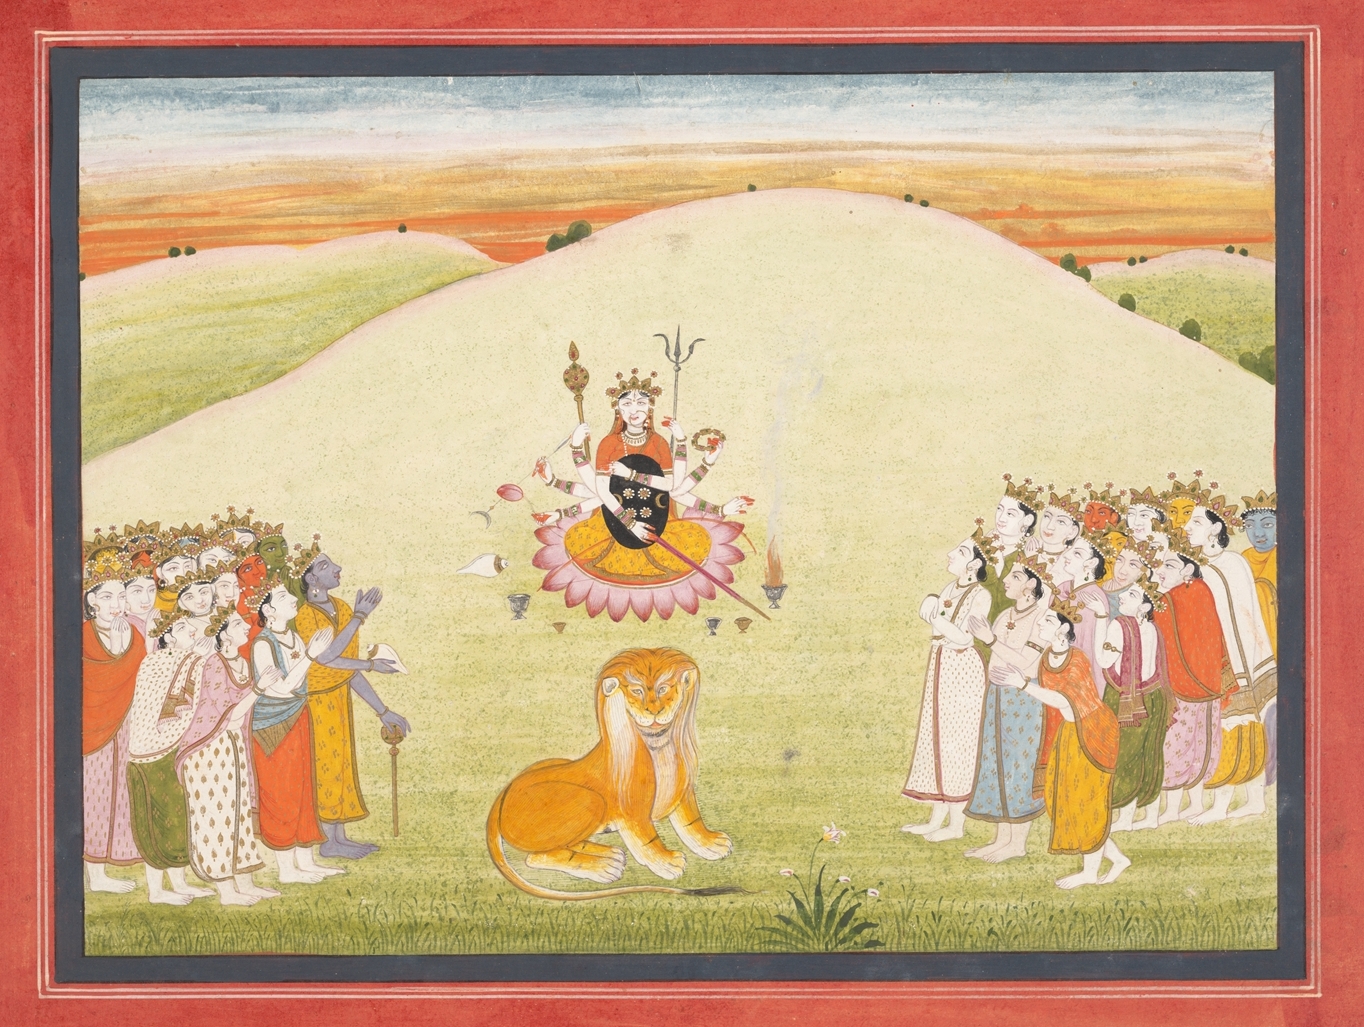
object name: folio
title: The Creation of Durga: Page from a Dispersed Markandeya Purana: (Stories of the Sage Markandeya)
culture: indian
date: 1810-1820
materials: ink, paper, watercolor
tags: lions,hills,gods,durga